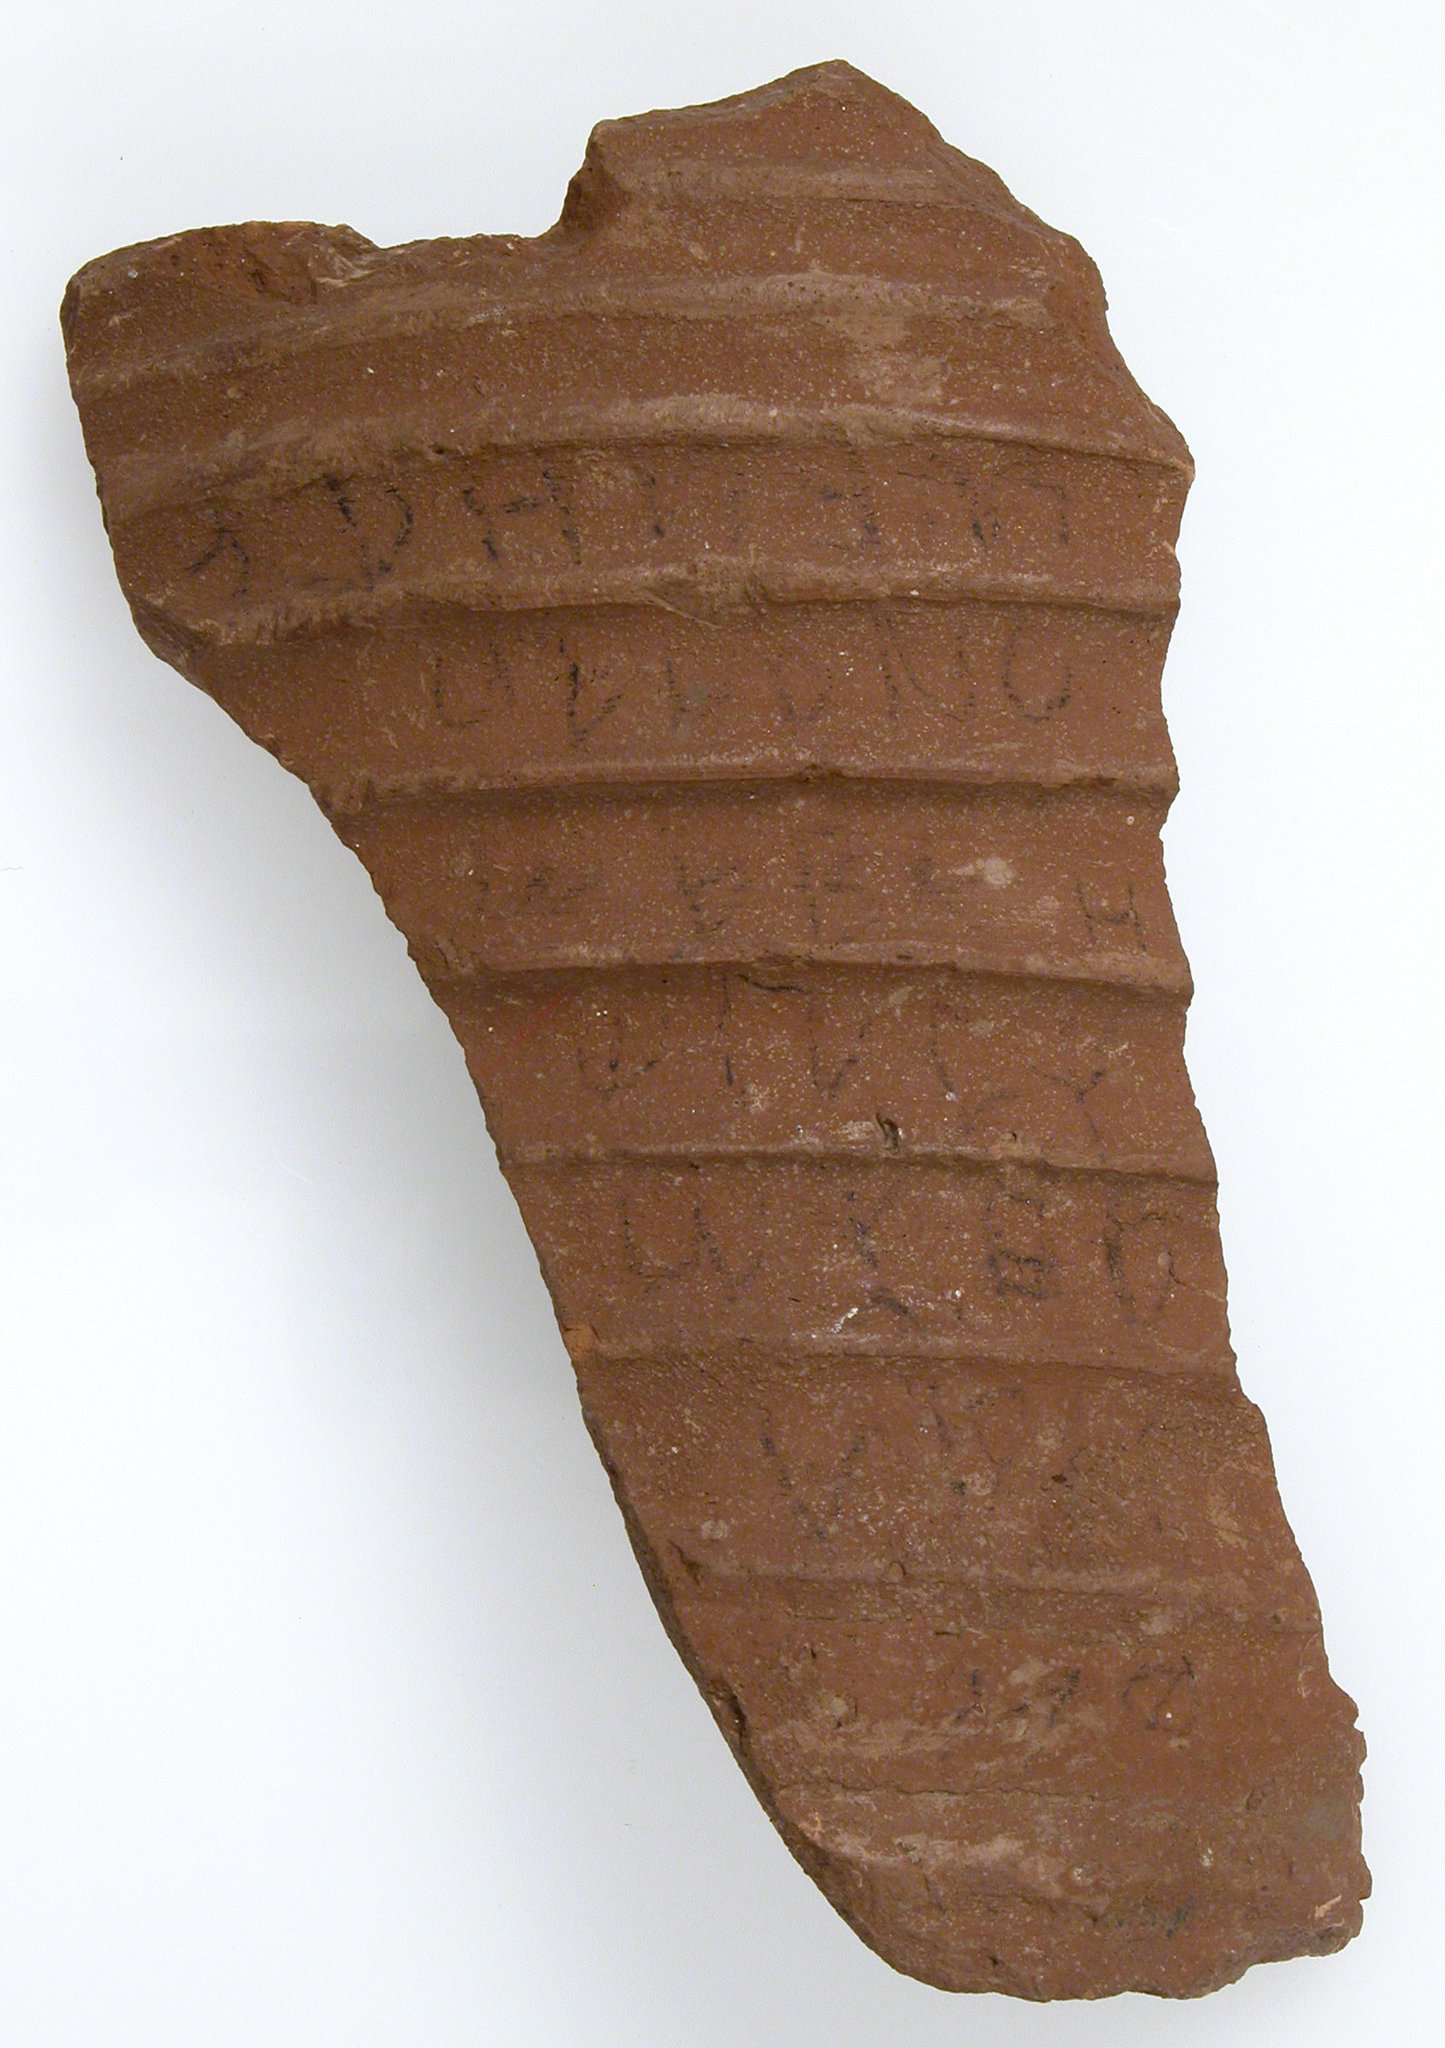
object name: ostrakon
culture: coptic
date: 601-700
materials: ink, pottery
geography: egypt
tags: coptic